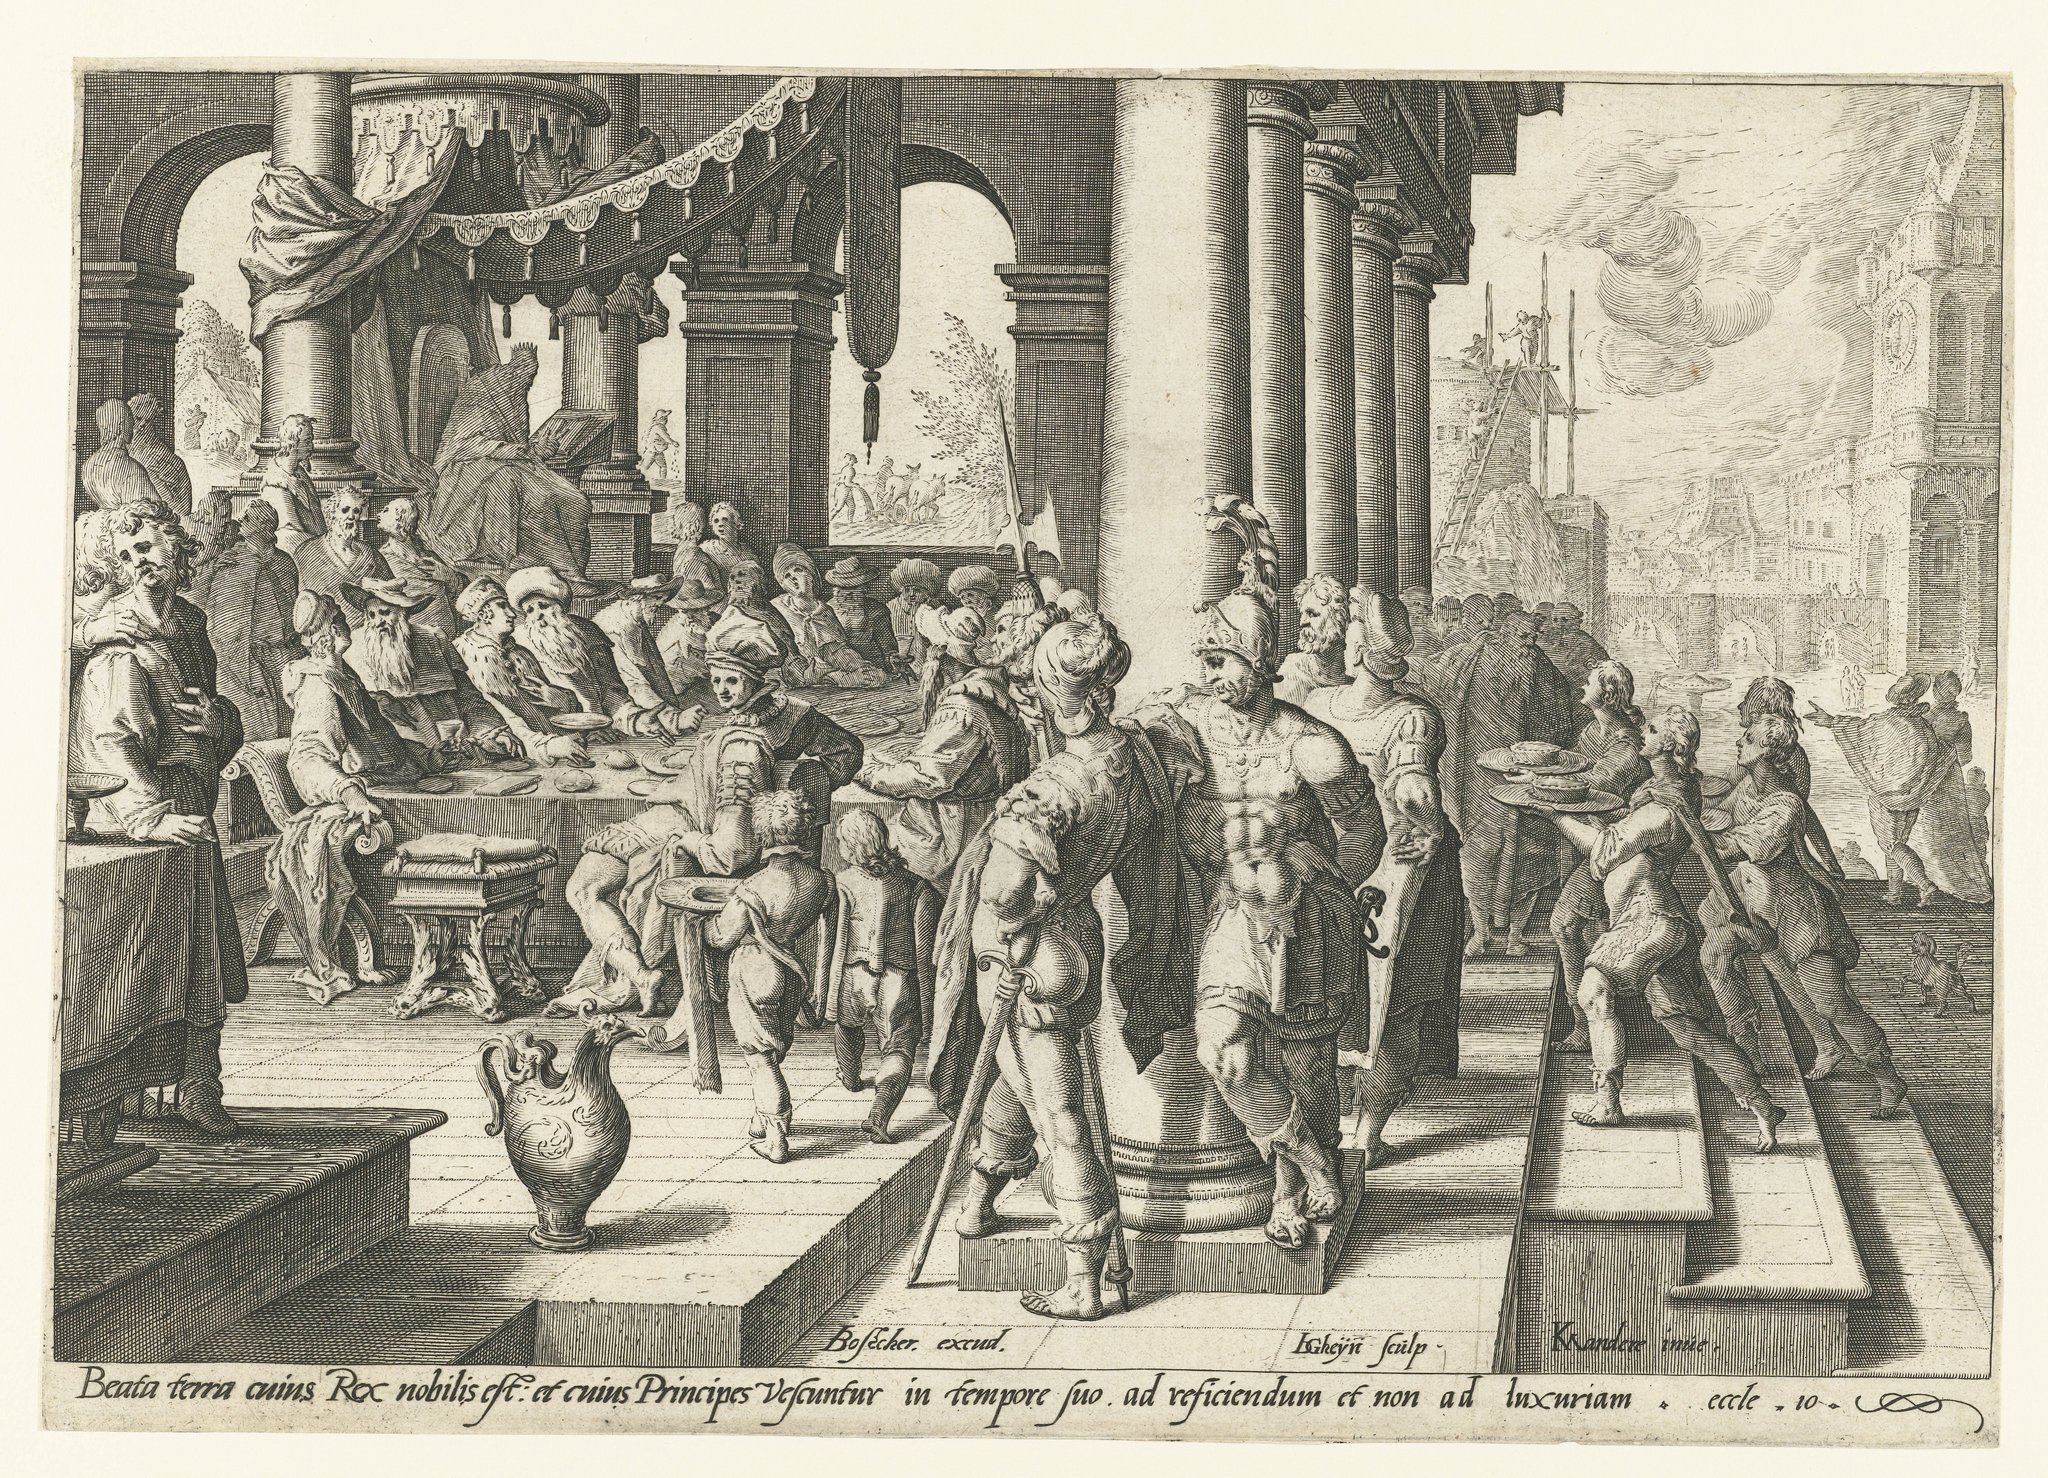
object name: print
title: Het land waarvan de zoon van adellijke afkomst de koning is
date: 1588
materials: paper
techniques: engraving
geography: netherlands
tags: allegory, personification of good government, king, good government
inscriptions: collector's mark: Lugt 2228a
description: In een voorportaal zit een man op een troon, een boek op een lessenaar naast zich. Aan zijn voeten gebruikt een groep mensen een de maaltijd. Bedienden komen aangelopen. Op de achtergrond is te zien dat buiten constructieve werkzaamheden gaande zijn: er wordt gezaaid, geploegd en een toren gebouwd of gerepareerd. Onder de voorstelling een regel Latijnse tekst (Eccles. 10:17).